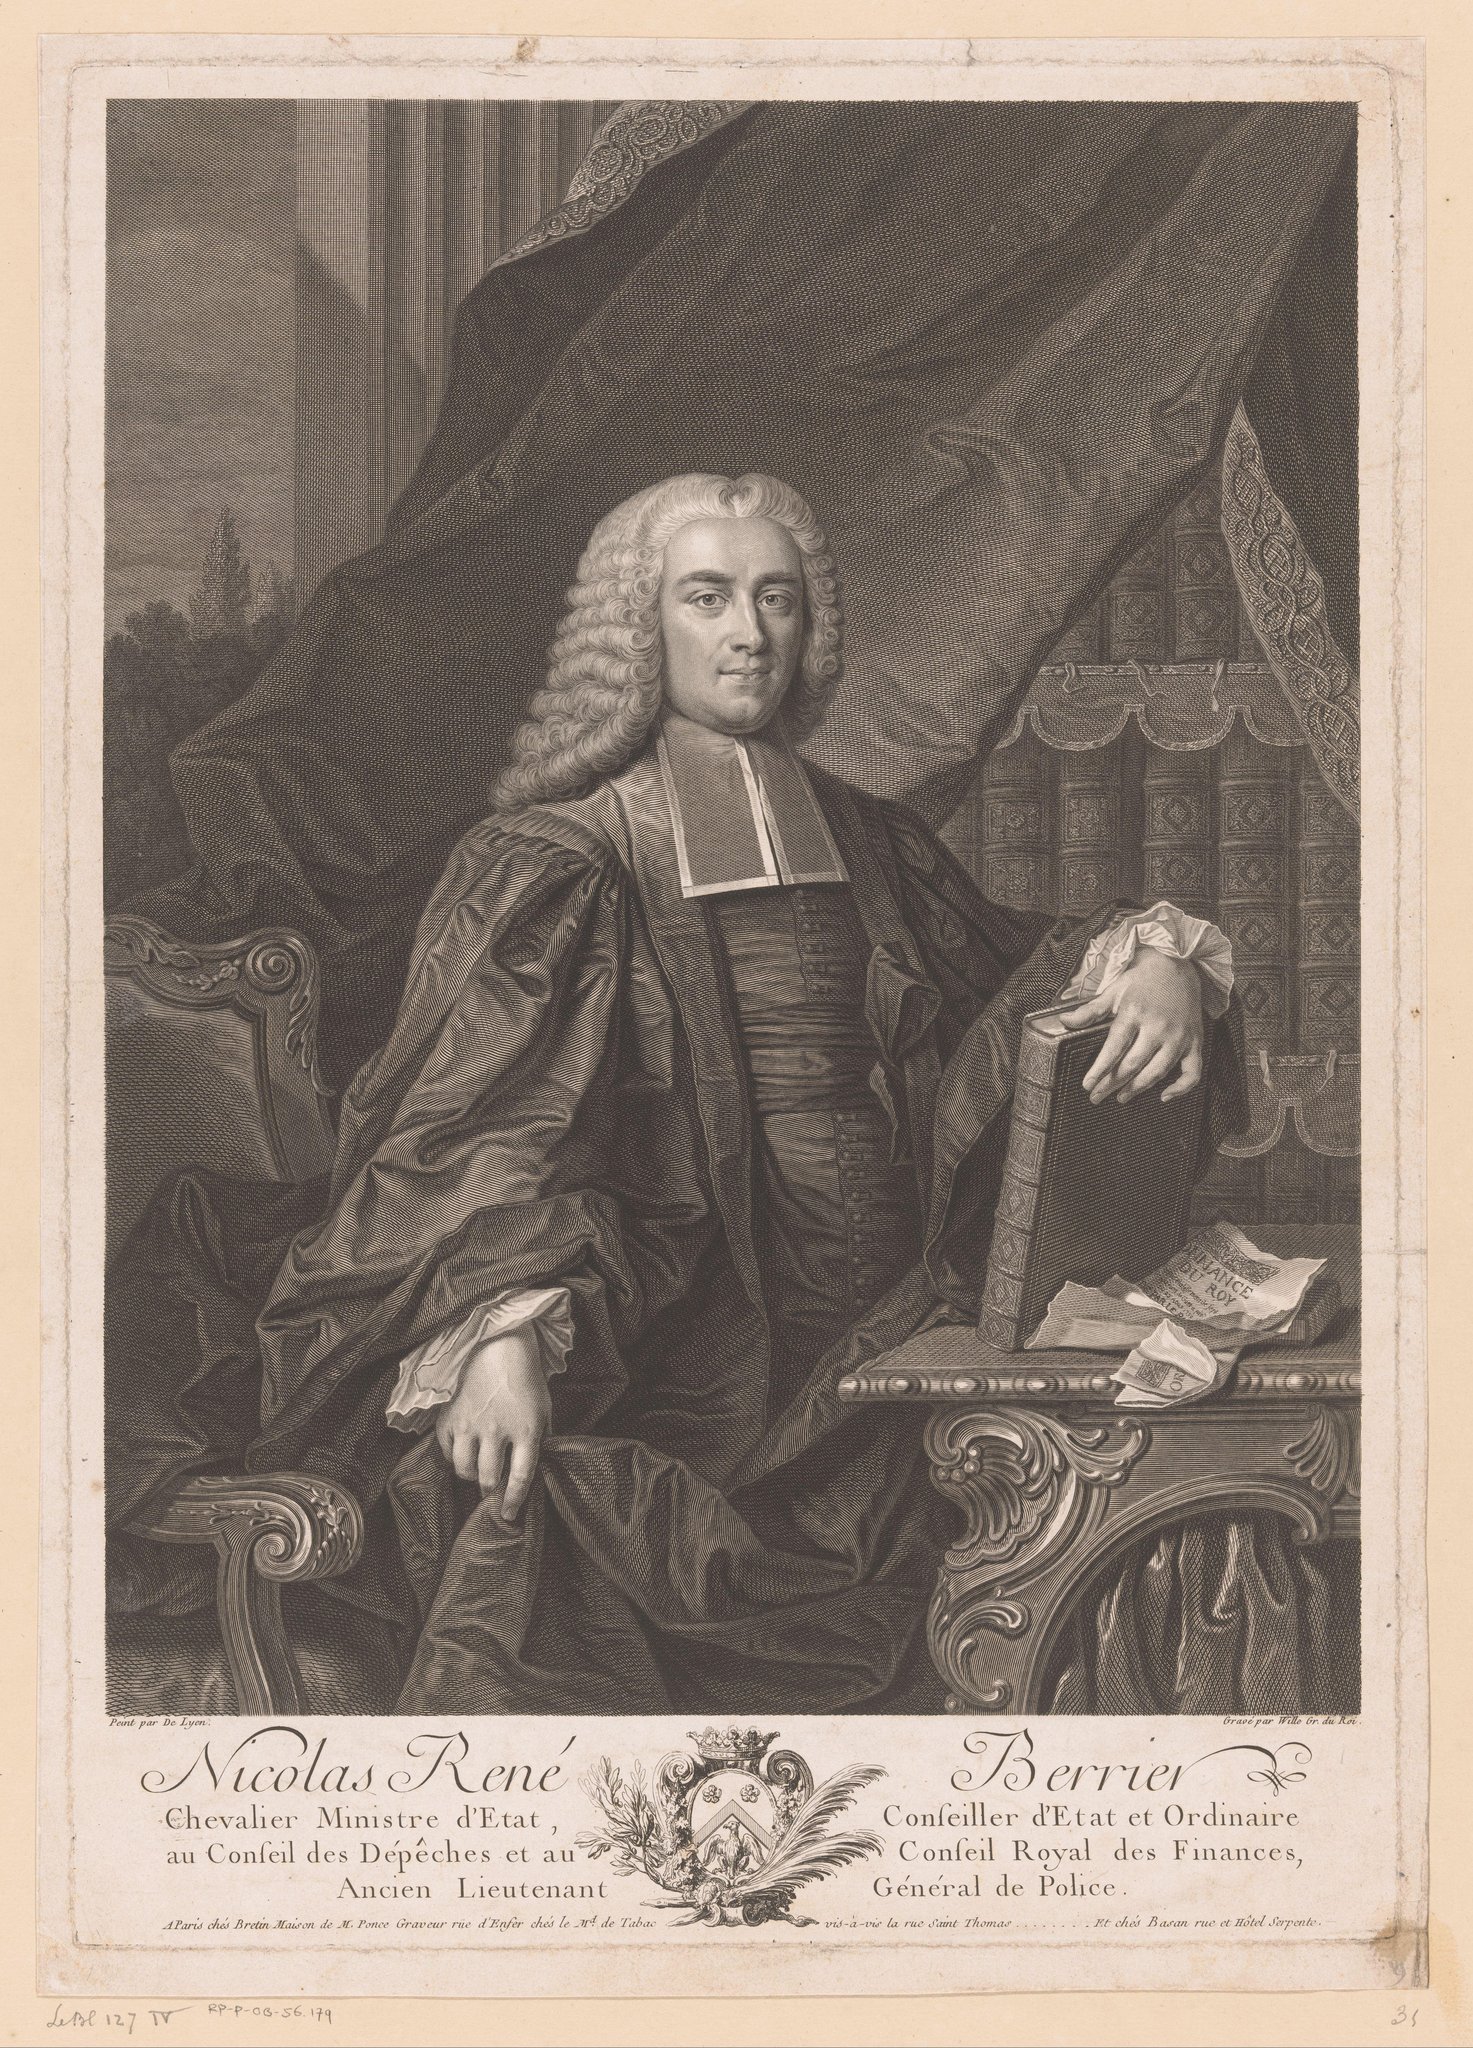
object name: print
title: Portret van Nicolas-René Berryer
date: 1780-1790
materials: paper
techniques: engraving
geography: paris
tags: paris, nicolas-rené berryer, historical persons